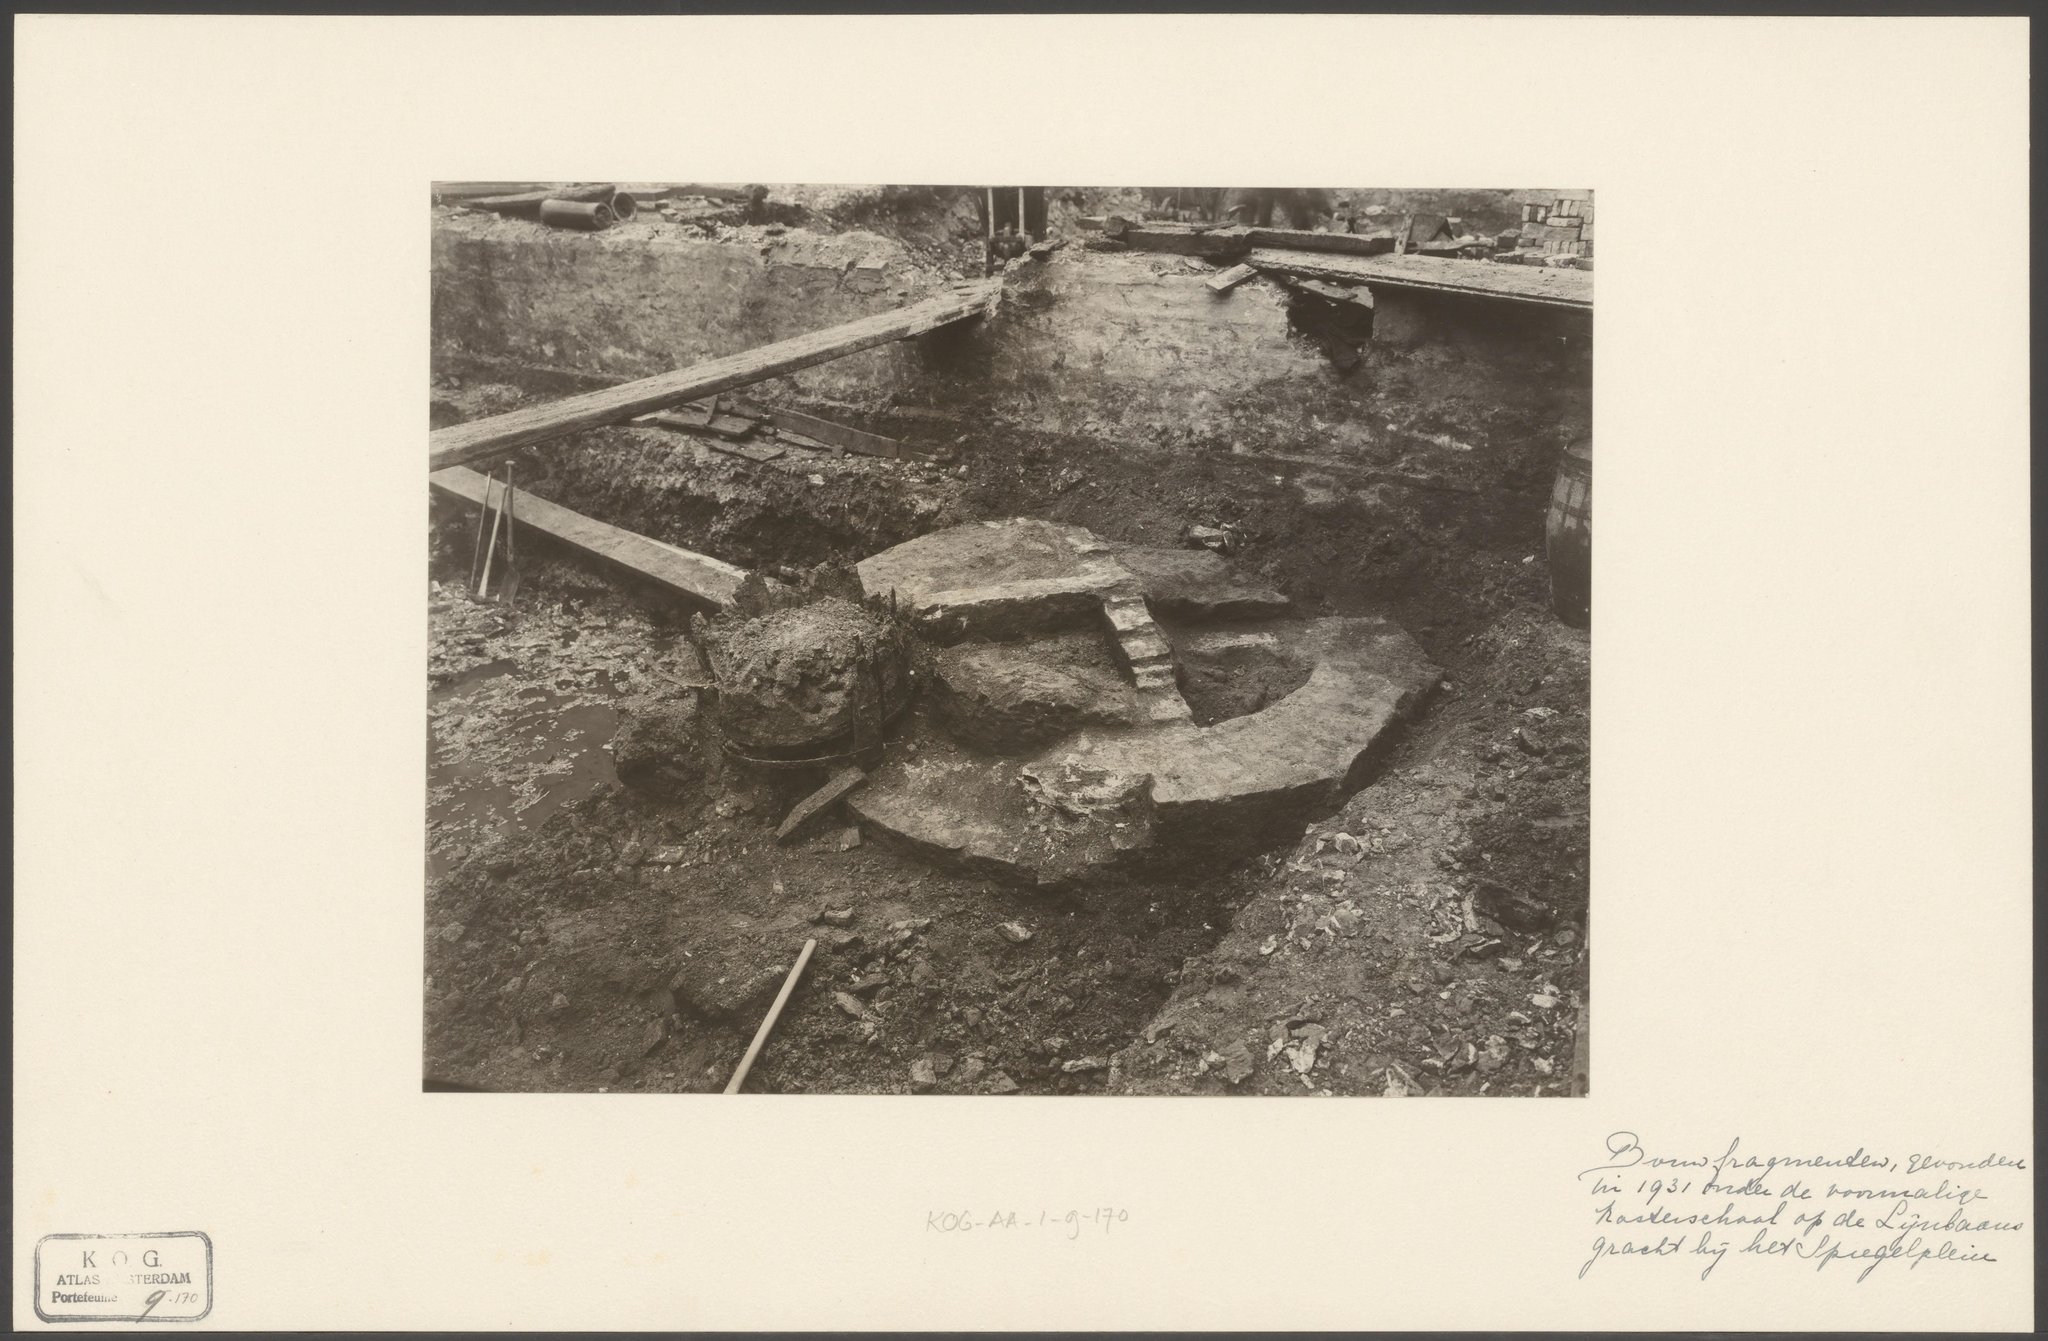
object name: photograph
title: Gezicht op gevonden bouwfragmenten bij verbouwing van een pand aan de Lijnbaansgracht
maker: Anonymous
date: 1931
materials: paper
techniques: gelatin silver print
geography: amsterdam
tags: city-view in general; 'veduta', building-site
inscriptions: inscription: ‘Bouwfragmenten, gevonden / in (...) bij het Spiegelplein’, collector's mark: ‘9.170’ Lugt 1641b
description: Onderwerpsrubriek binnen de Atlas Amsterdam: 2e Laurierdwarsstraat (Vuile Weespad), Leidschegracht, Leidschekade, Leidscheplein, Leidschestraat, v. Lennepkade, Lijnbaansgracht, Lauriergracht, Leliedwarsstraat, Leliegracht, Lindengracht, Lombardsteeg, Looiersgracht, Looiersstraat (Nieuwe), Leidekkerssteeg.